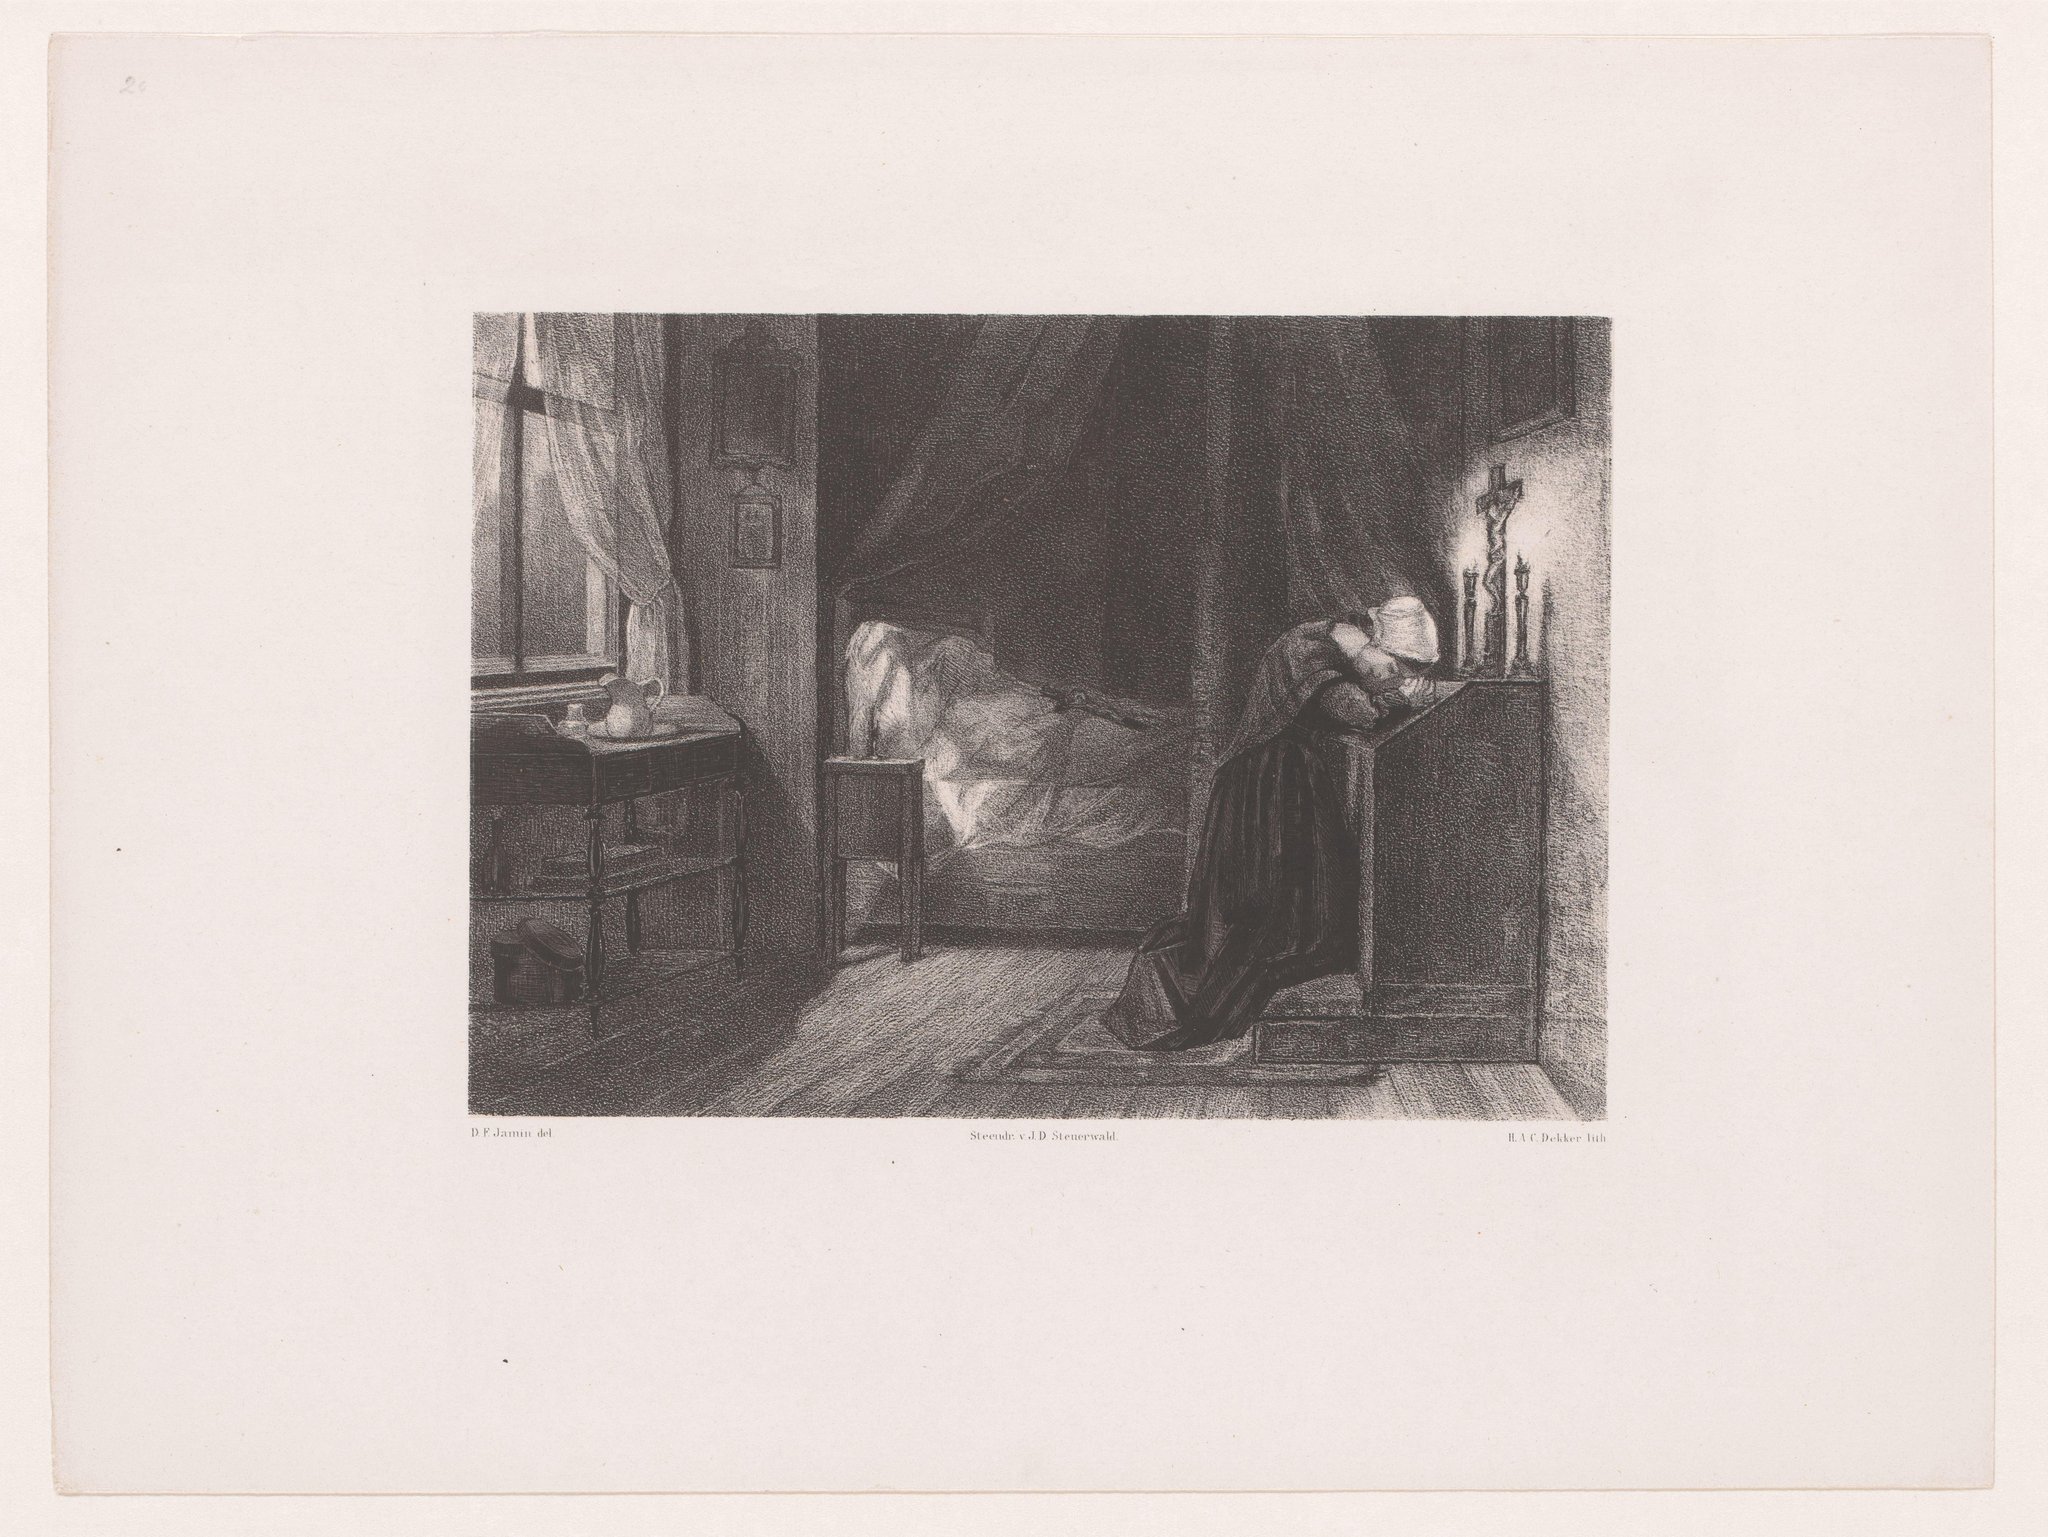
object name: print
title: Vrouw biddend bij overledene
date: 1846-1863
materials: paper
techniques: lithograph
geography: amsterdam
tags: deathbed, the corpse, one person praying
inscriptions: collector's mark: Lugt 2228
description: De prent en het schilderij verschillen op een paar punten. Op het schilderij staan andere objecten op de tafel onder het raam en er hangt een rond, in plaats van vierkant, schilderij boven de biddende vrouw.